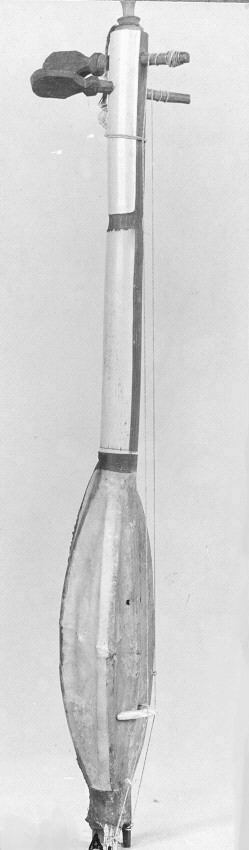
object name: gunbri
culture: syrian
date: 1867-1900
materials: bamboo, wood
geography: syria